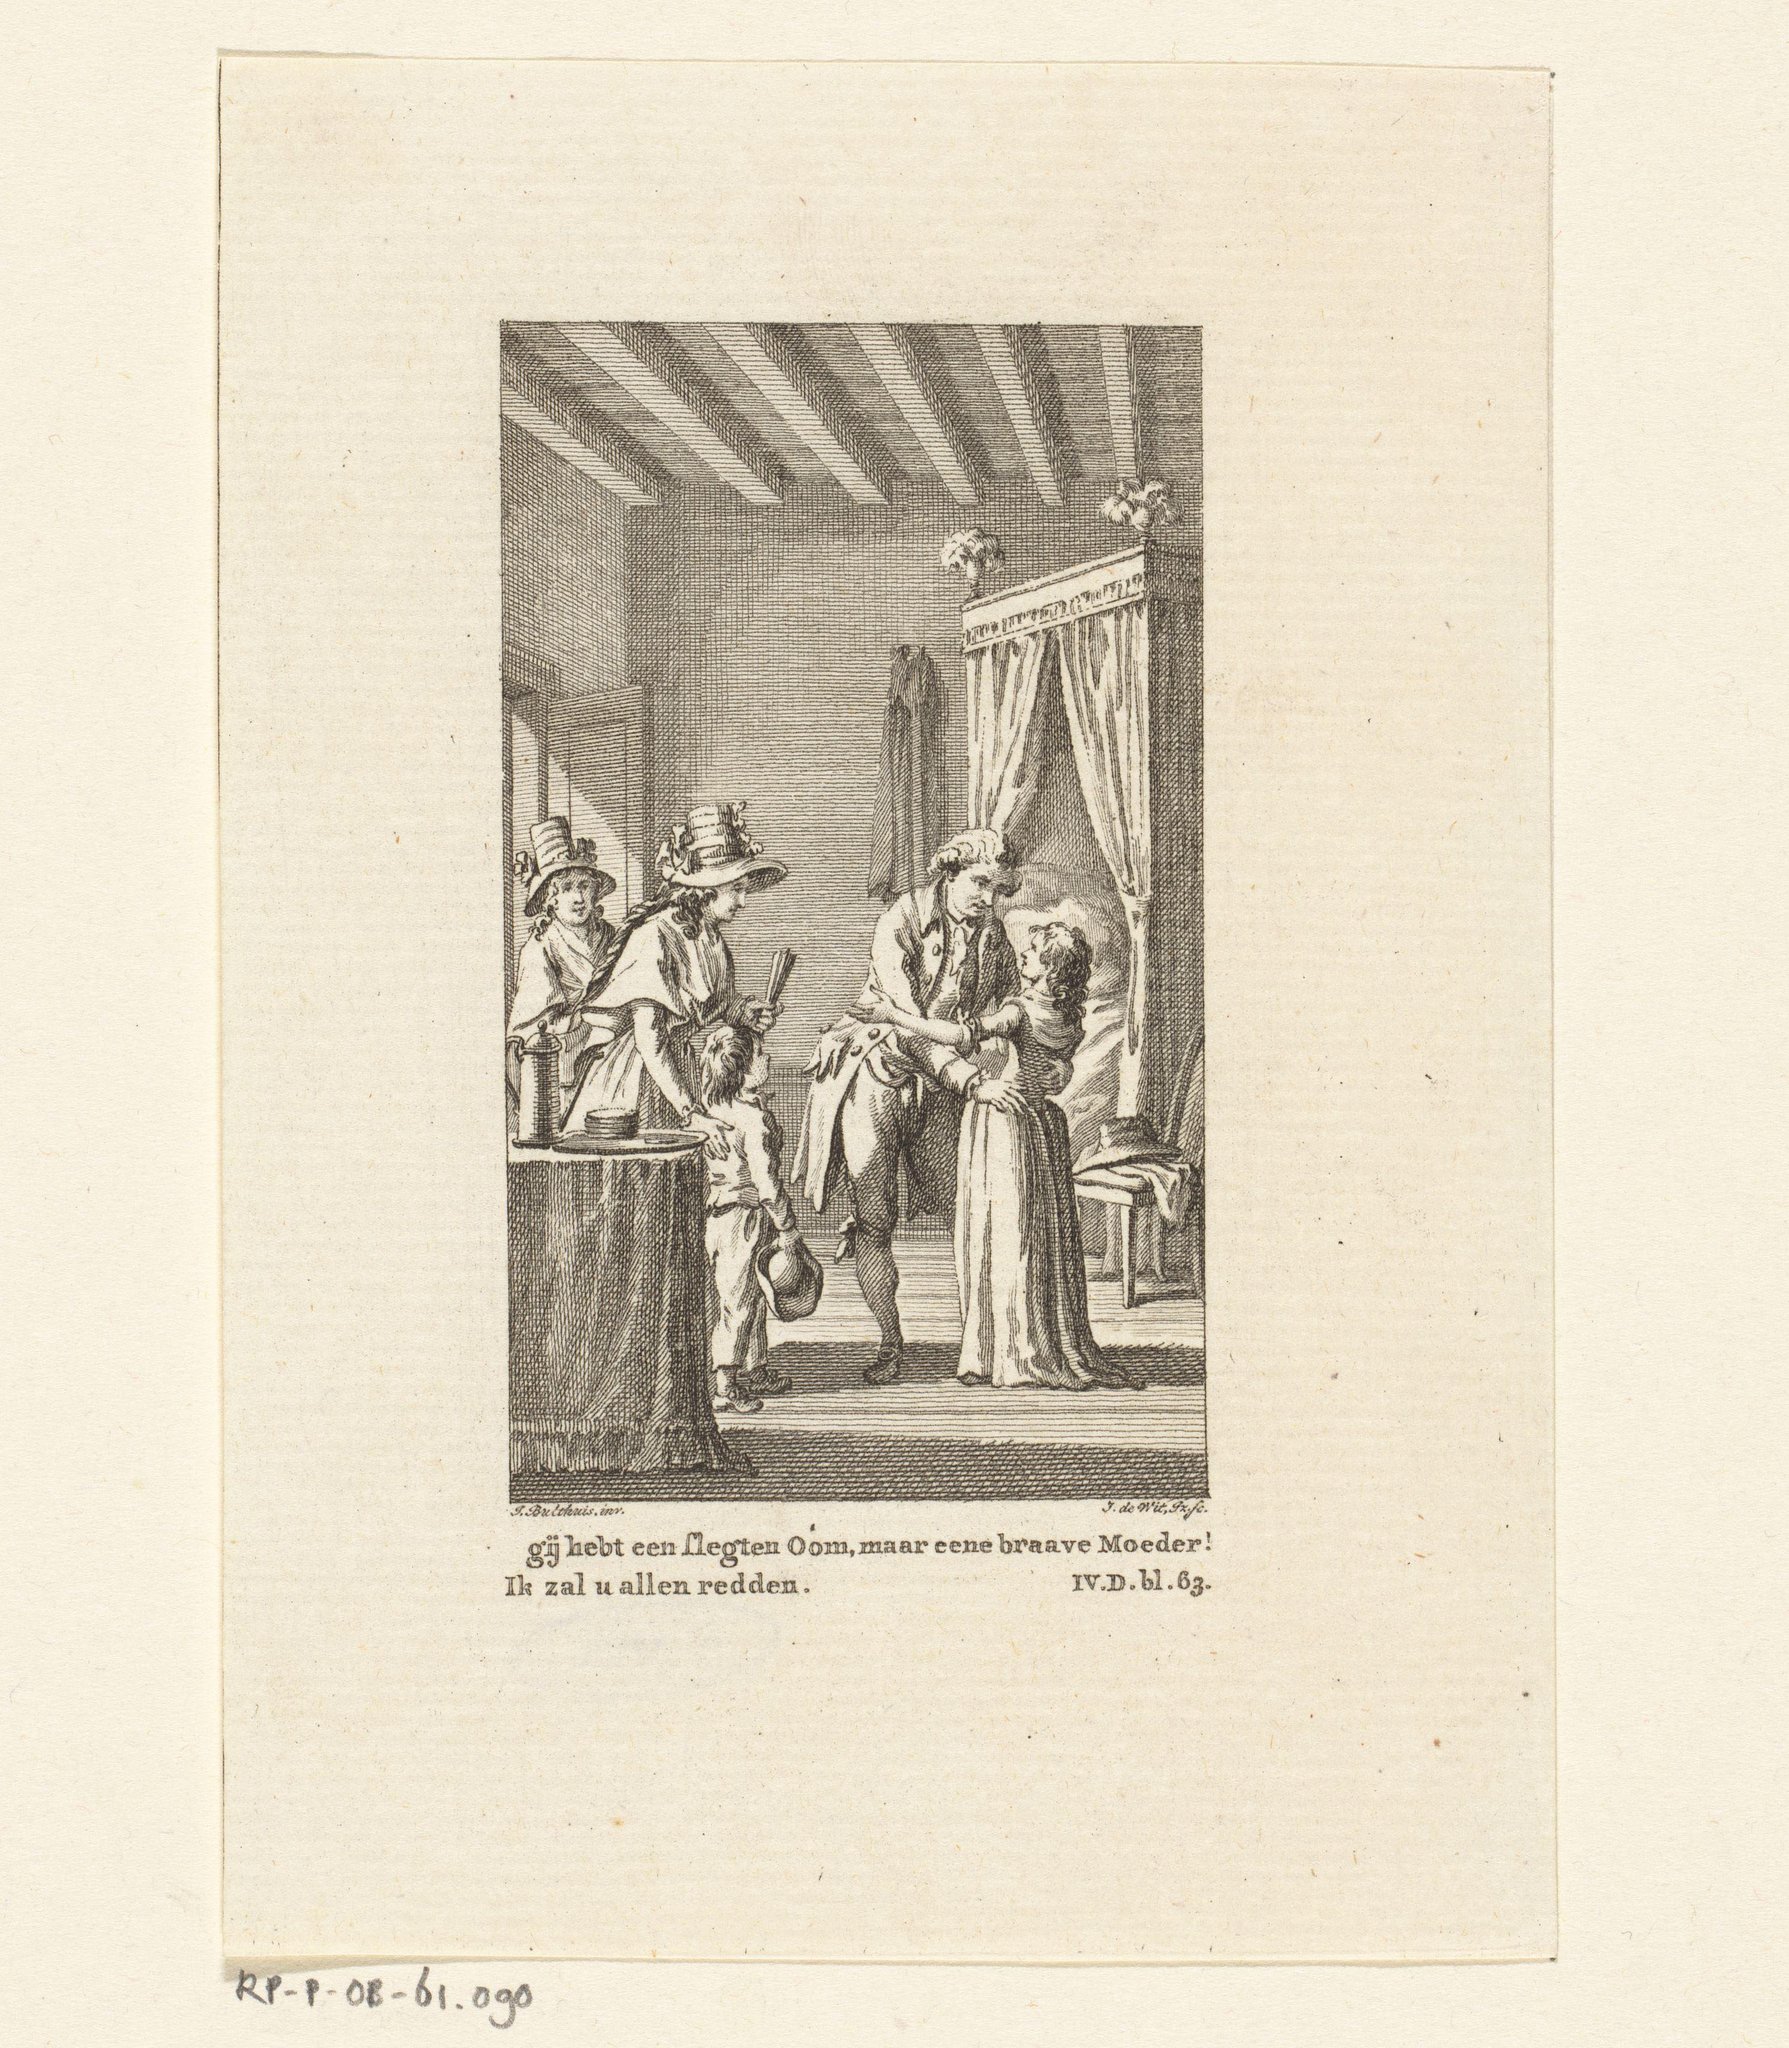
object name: book illustration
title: Vijf figuren in een slaapkamerinterieur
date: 1754-1809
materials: paper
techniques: etching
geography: haarlem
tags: family life at home, bedroom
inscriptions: collector's mark: Lugt 2228